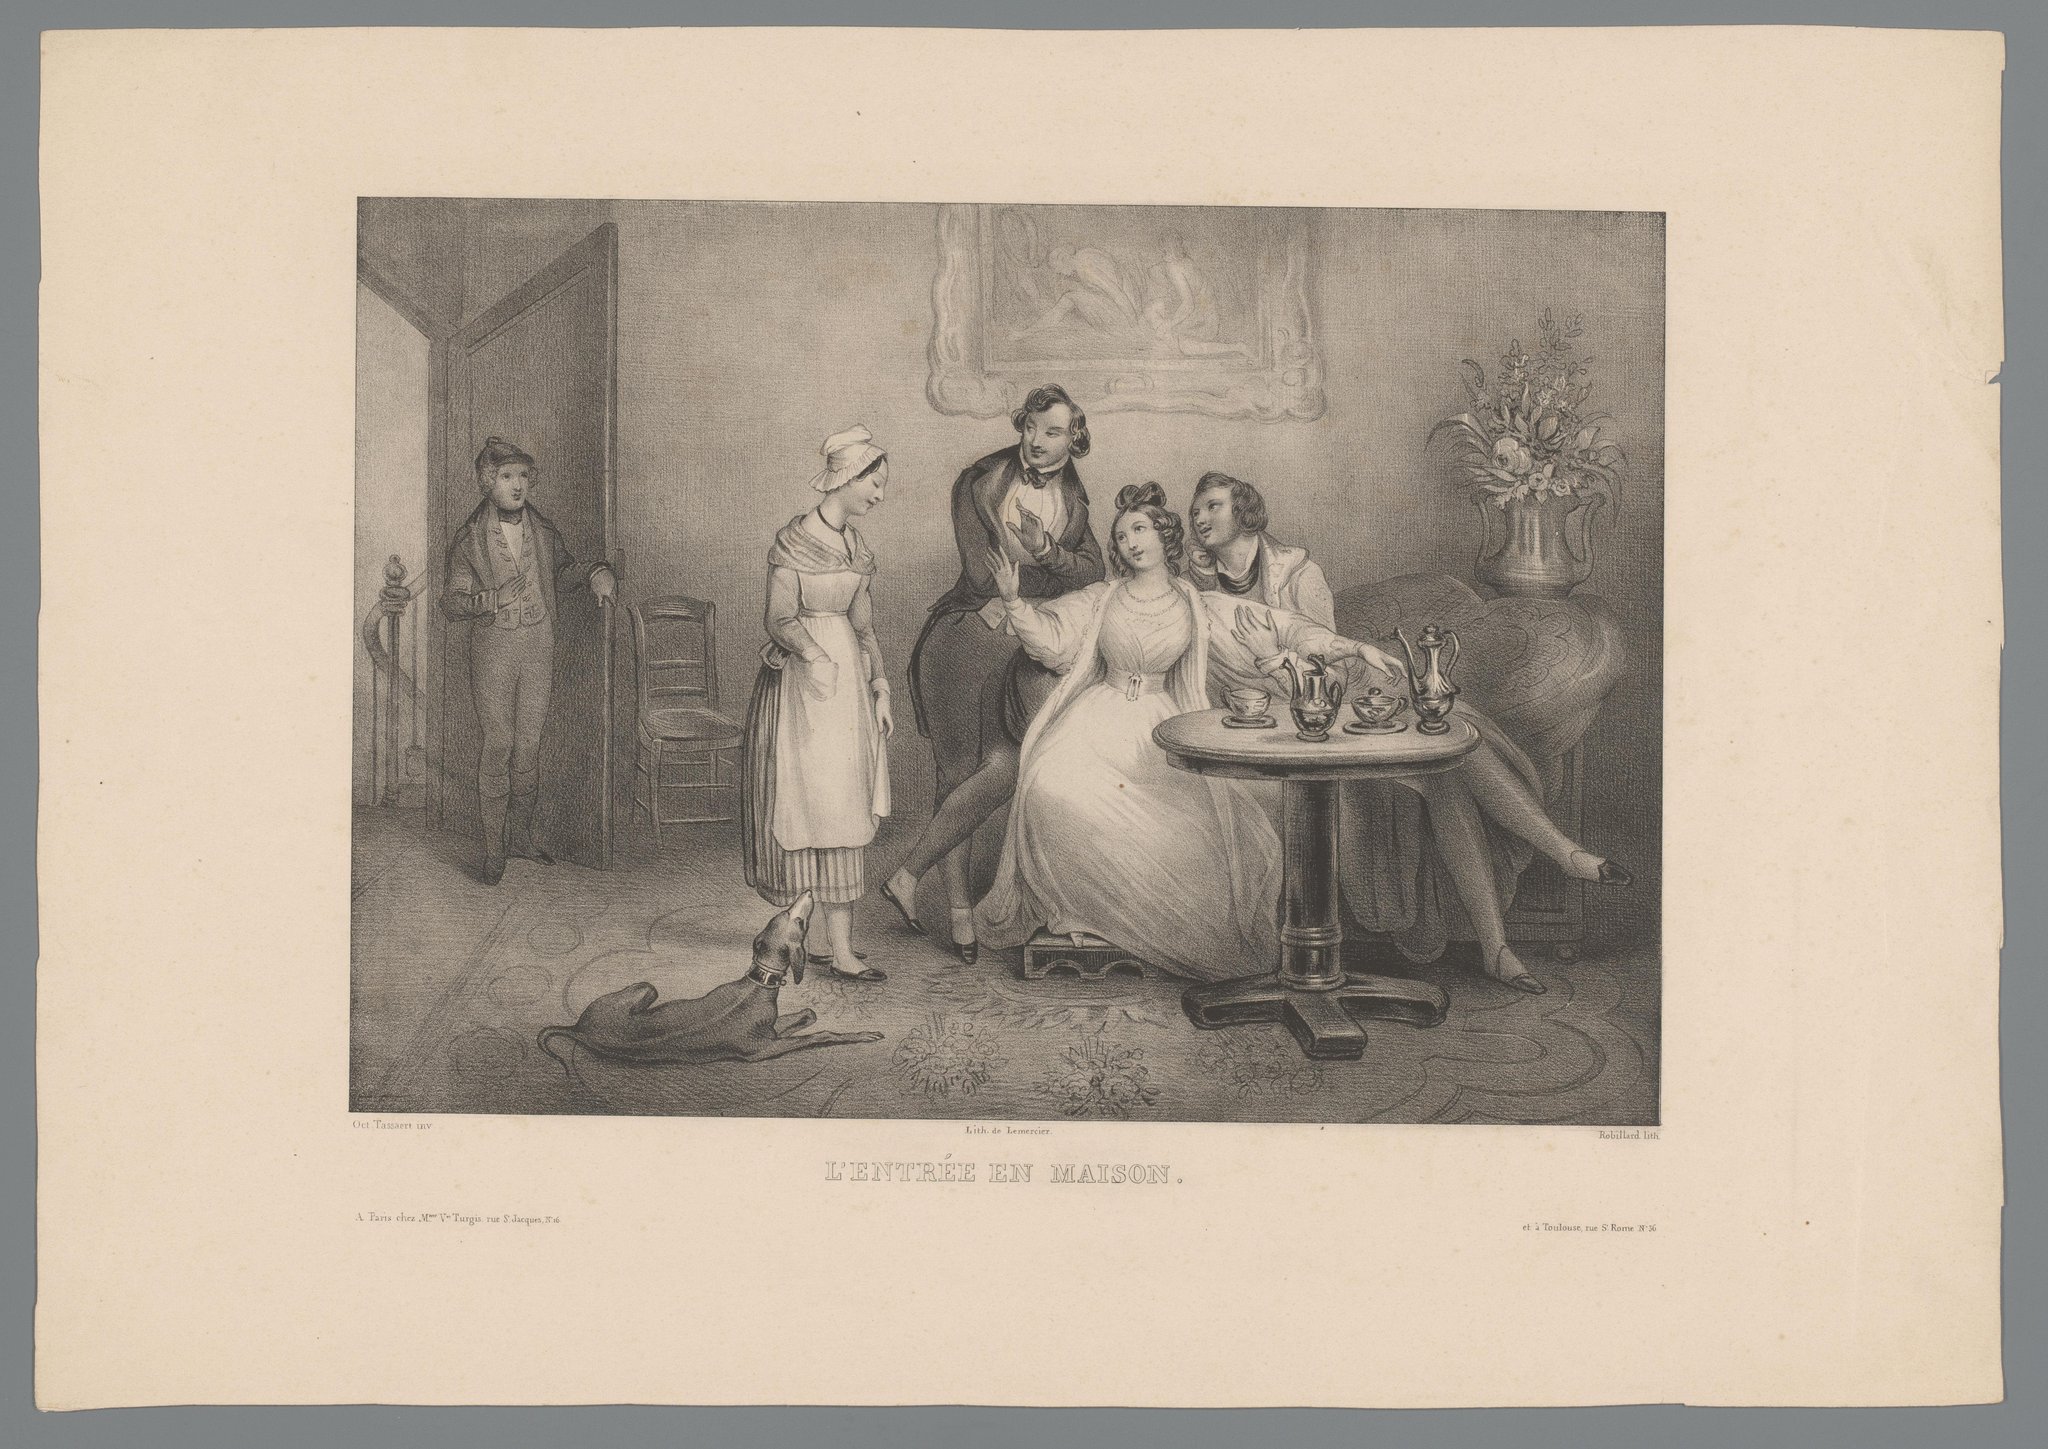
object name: print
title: L'entrée en maison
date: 1839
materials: paper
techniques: lithograph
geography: paris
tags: adolescent, young woman, maiden (+ four persons), meeting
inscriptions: collector's mark: Lugt 2228